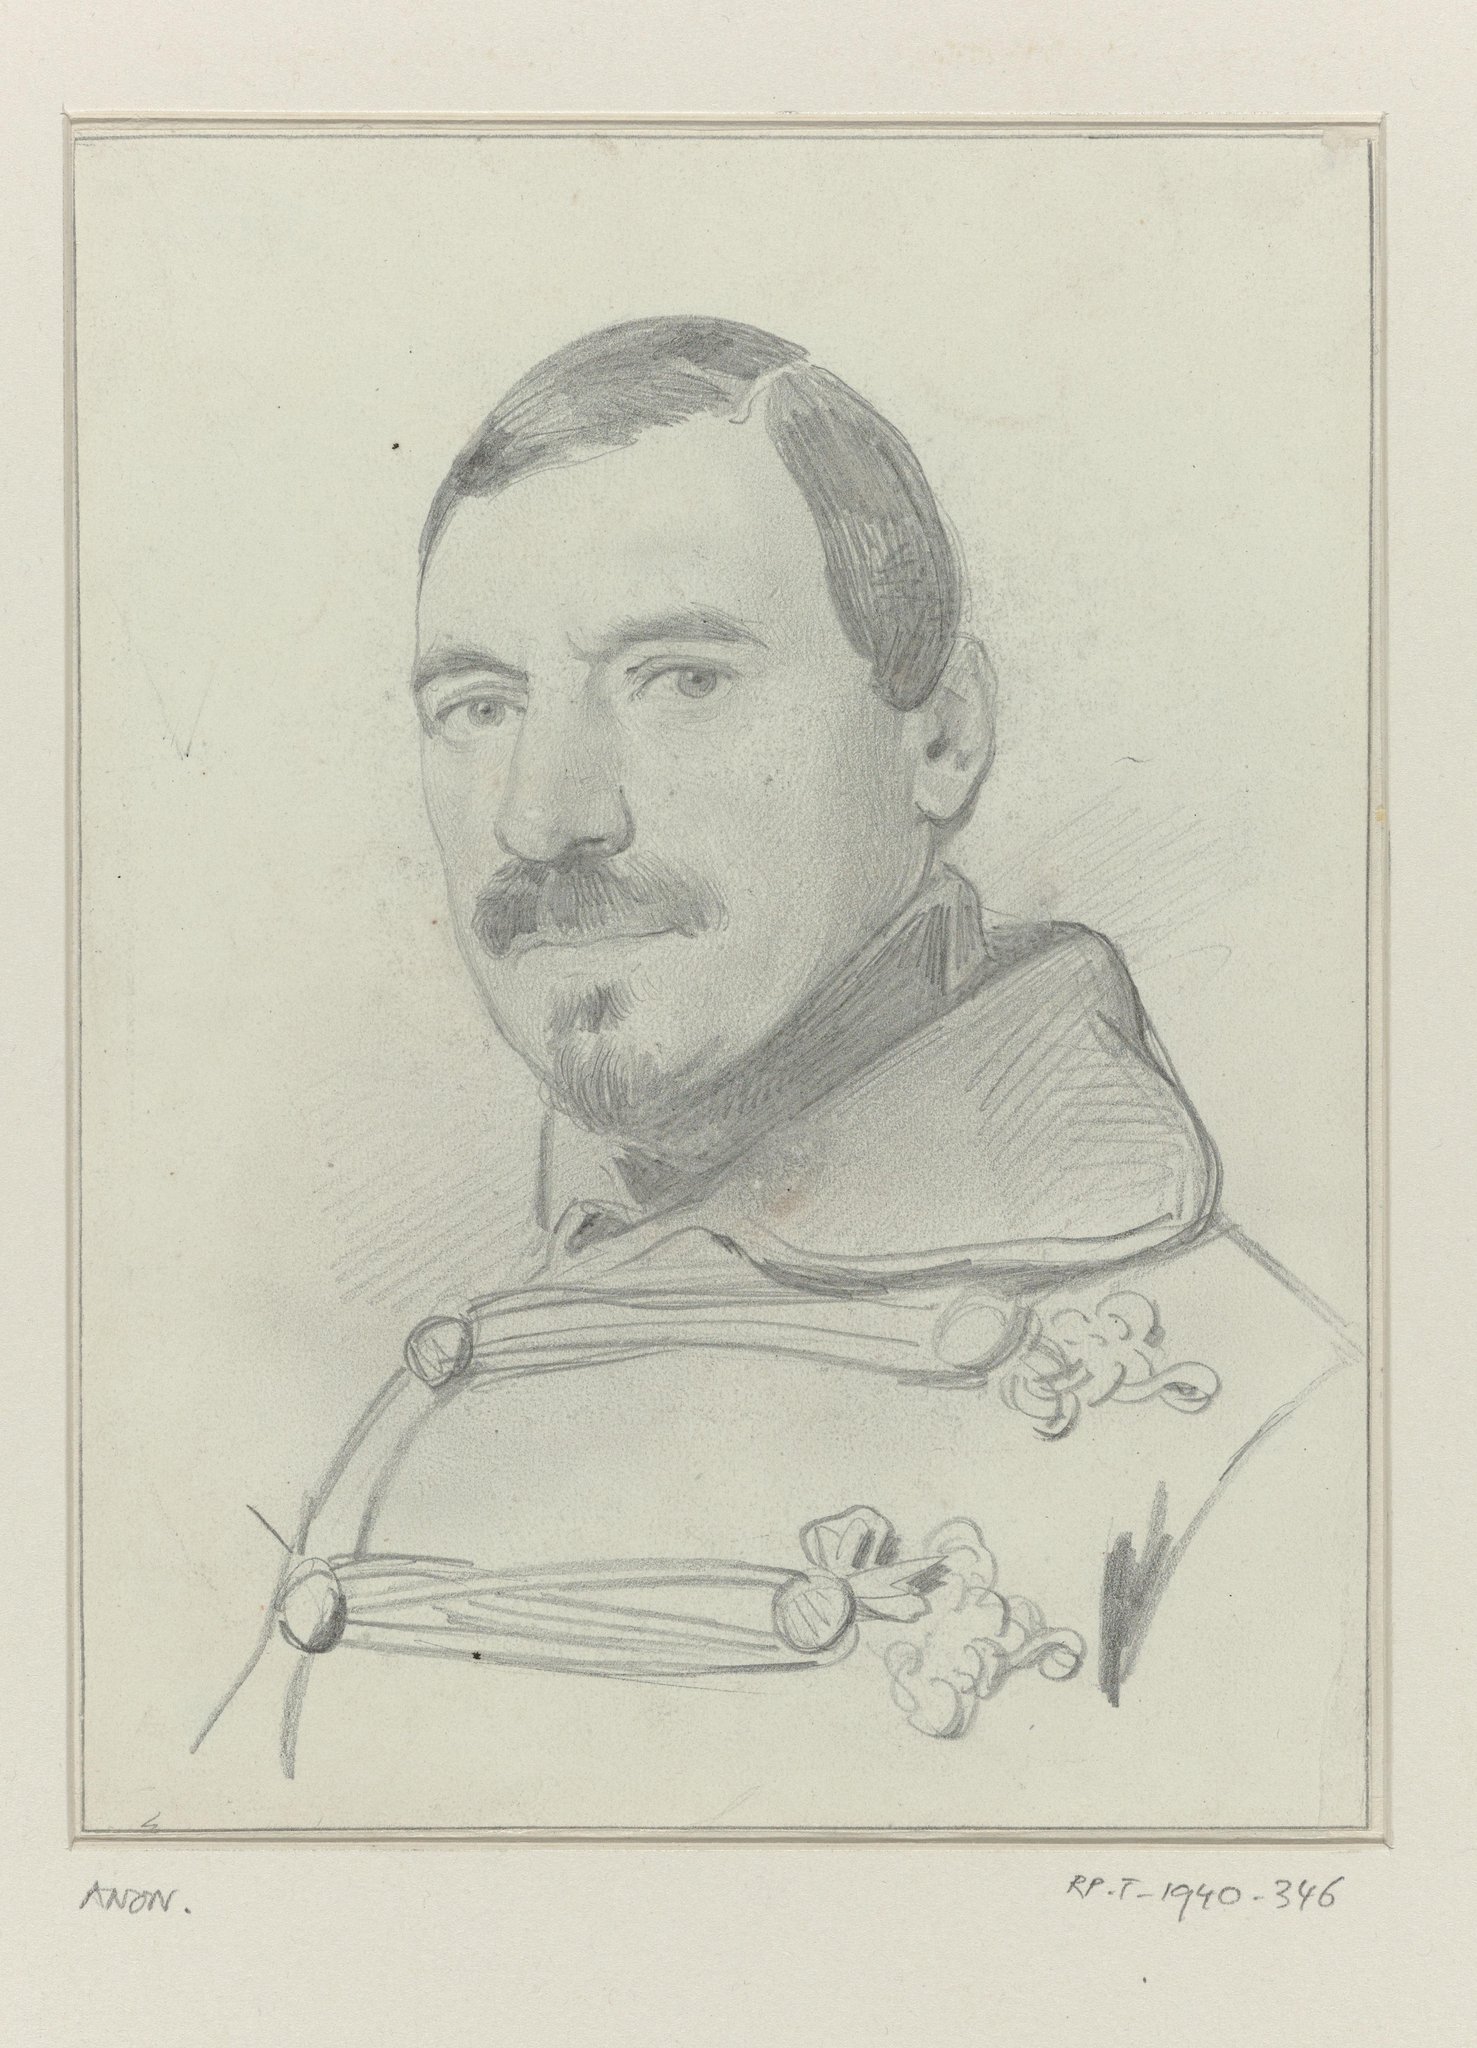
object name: drawing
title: Portret van Charles Louis Verboeckhoven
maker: Anonymous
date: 1812-1934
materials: paper, pencil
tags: brussels, draughtsman, charles louis verboeckhoven, historical persons, portrait, self-portrait of painter, portrait, self-portrait of artist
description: Portret van de schilder Charles Louis Verboeckhoven.